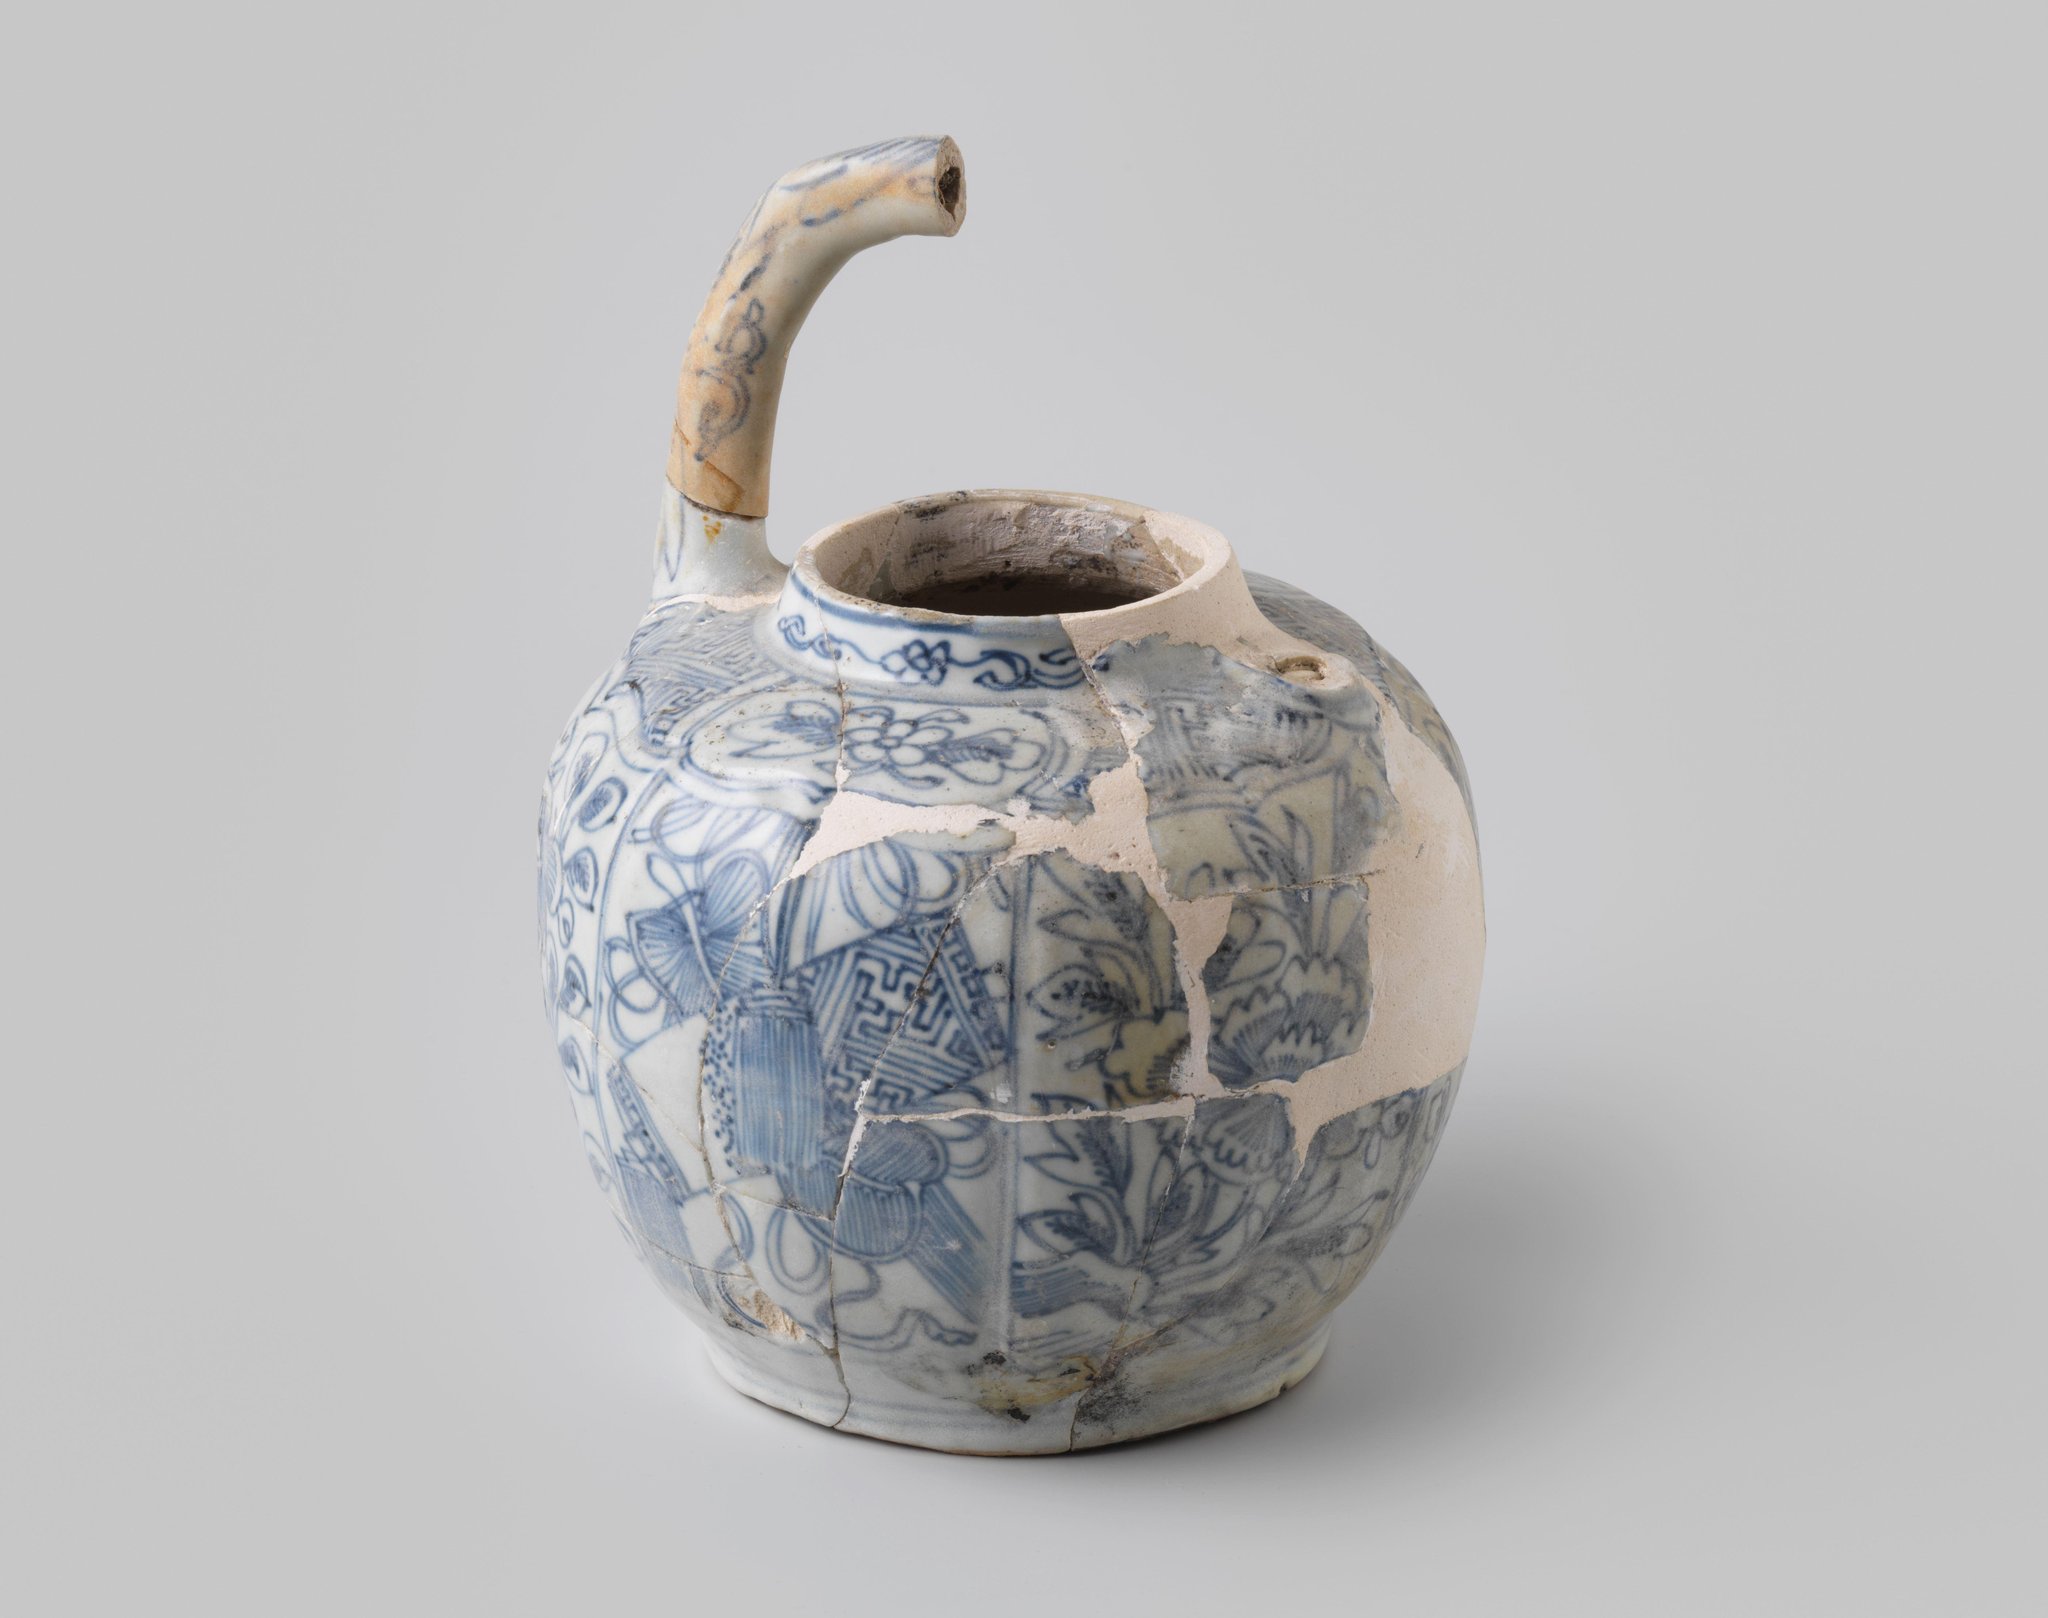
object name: wijnstoop, wijnkaraf, wijnkan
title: Winepot with handle of Chinese porcelain from the wreck of the Dutch East Indiaman Witte Leeuw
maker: Anonymous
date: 1613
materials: bone china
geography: jingdezhen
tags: verenigde oostindische compagnie, sint-helena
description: Winepot with a handle and spout. The panels decorated with peonies and symbols. Shoulder and cover are decorated with two cartouches with floral sprays on a fine diaper pattern. The handle is decorated with various motives: dots and flower sprays. The spout with flame motives and stylized jewels and the cover with floral sprays and cartouches on diaper pattern. The neck with two sketchy flower sprays.